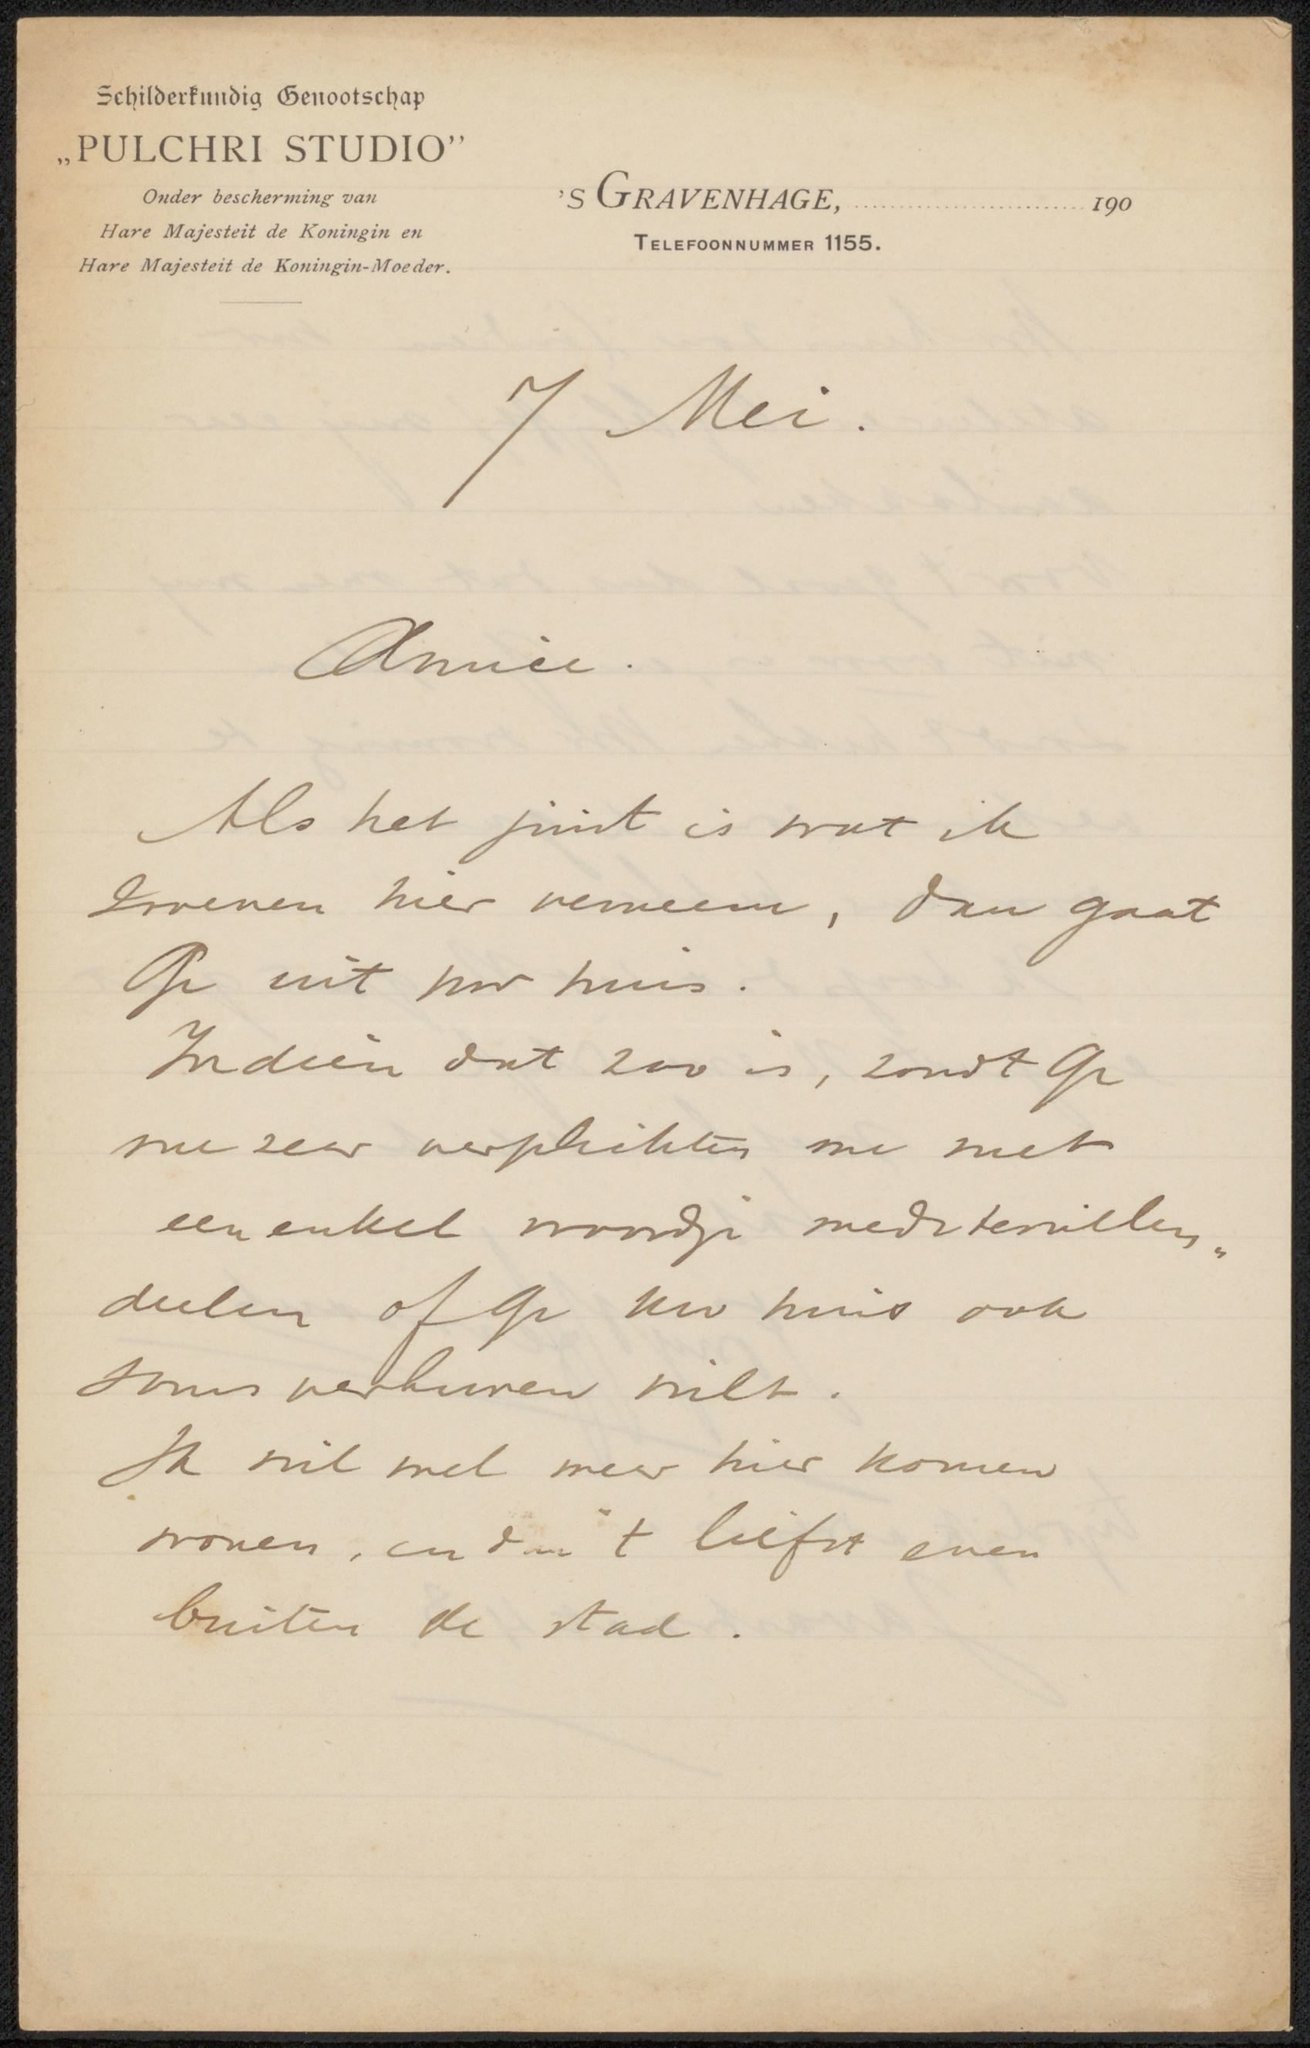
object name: letter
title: Brief aan Philip Zilcken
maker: tony lodewijk george offermans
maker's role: genreschilder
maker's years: 1854-1911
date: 1900-1911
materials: ink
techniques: pen, printing, writing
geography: the hague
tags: painter, draughtsman, philip zilcken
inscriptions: collector's mark: ‘RPK’